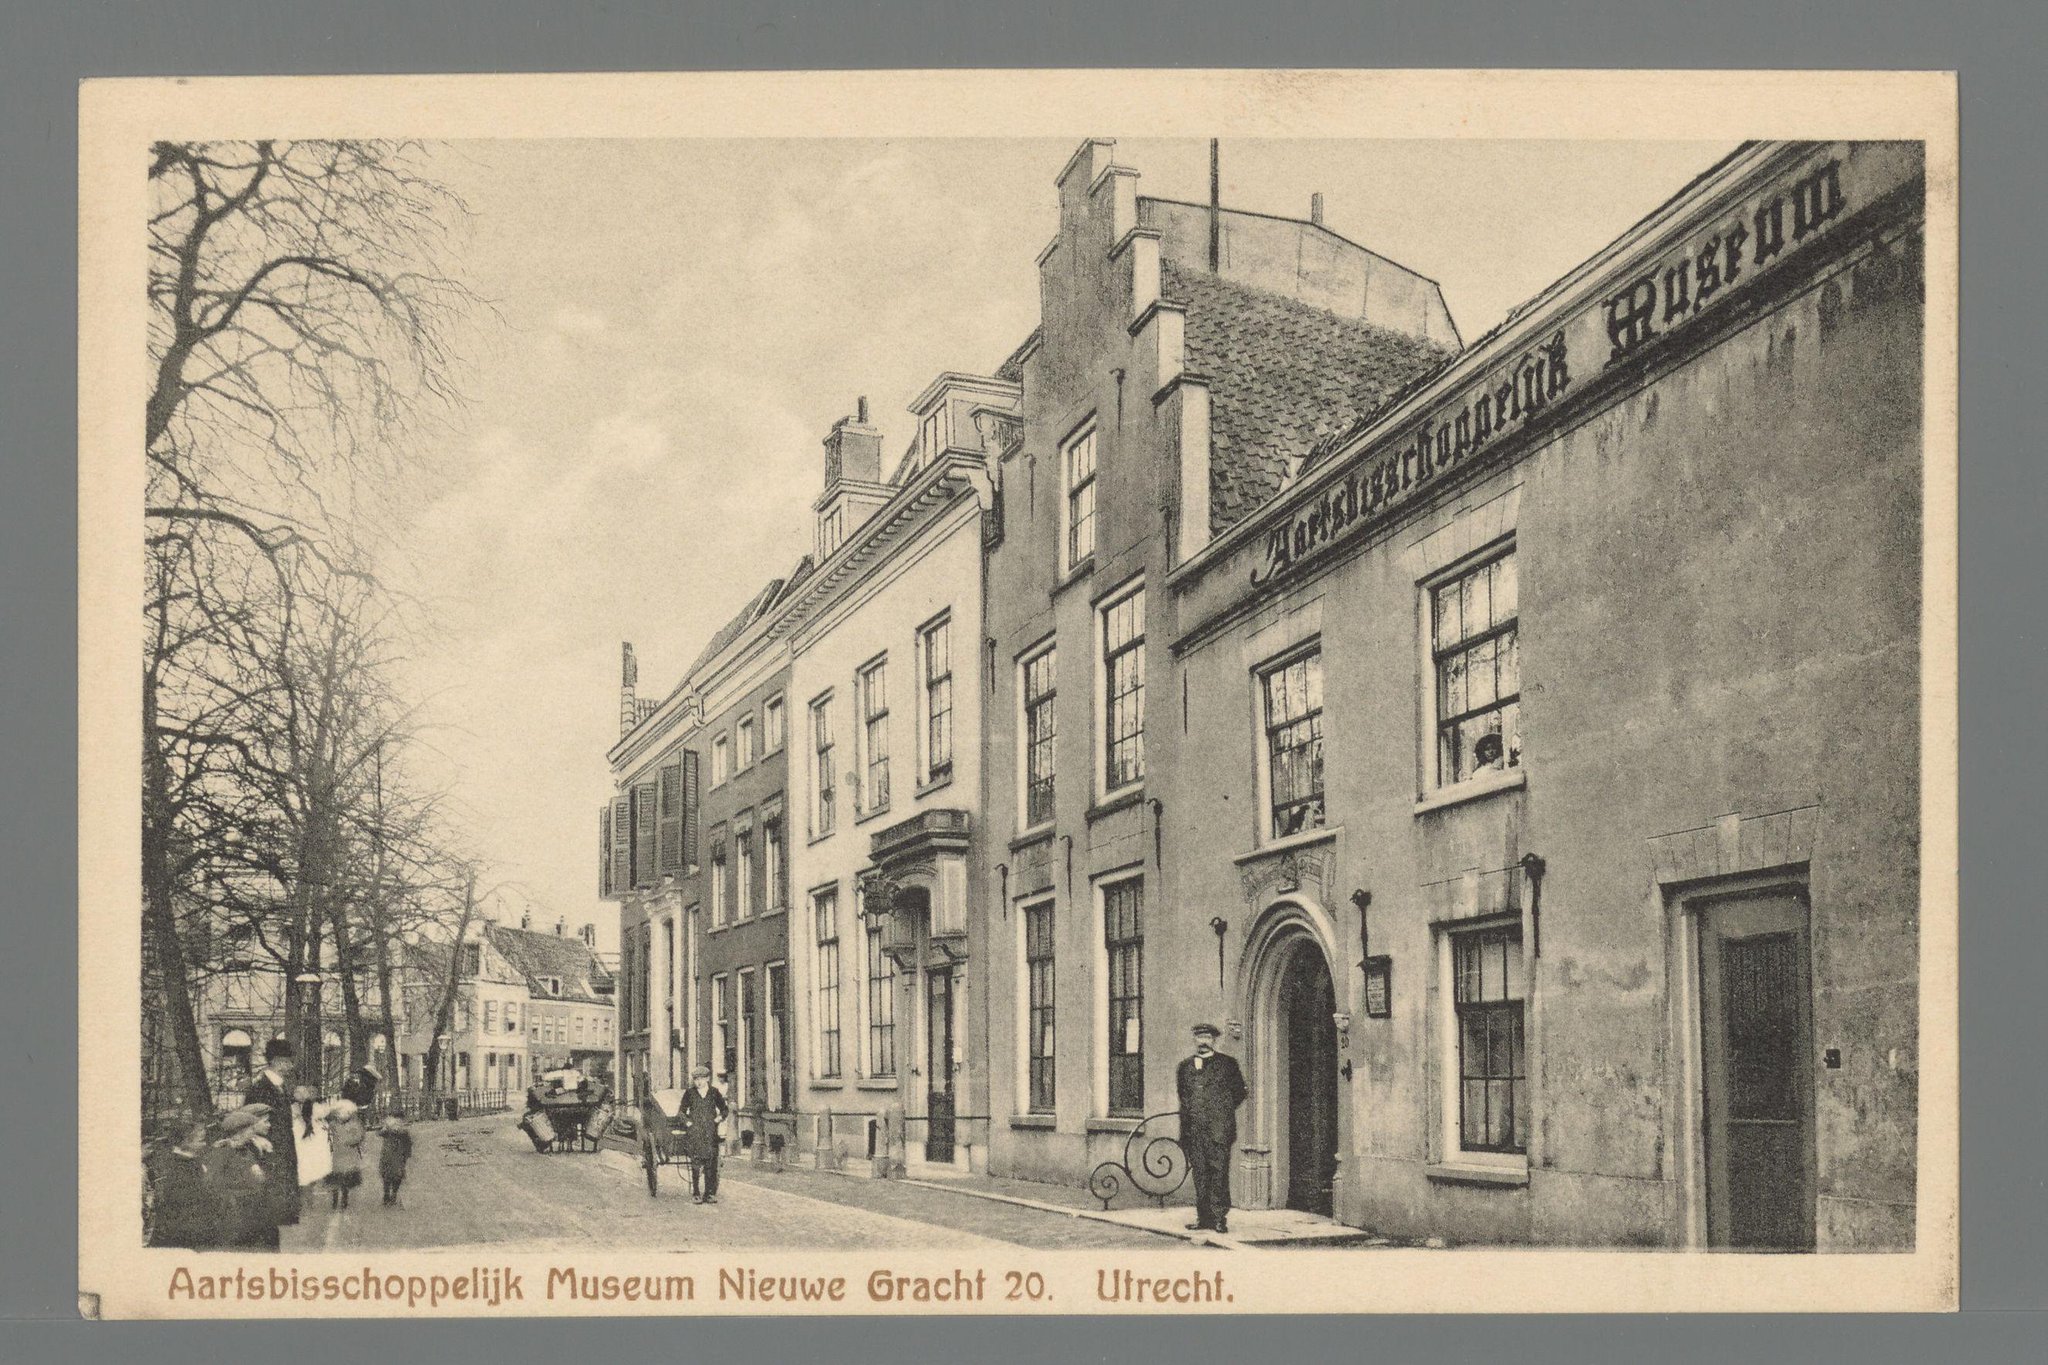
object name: photomechanical print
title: Aartsbisschoppelijk Museum Nieuwe Gracht 20. Utrecht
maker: Anonymous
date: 1913-1921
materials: cardboard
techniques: photograph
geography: utrecht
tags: permanent exhibition, museum, street